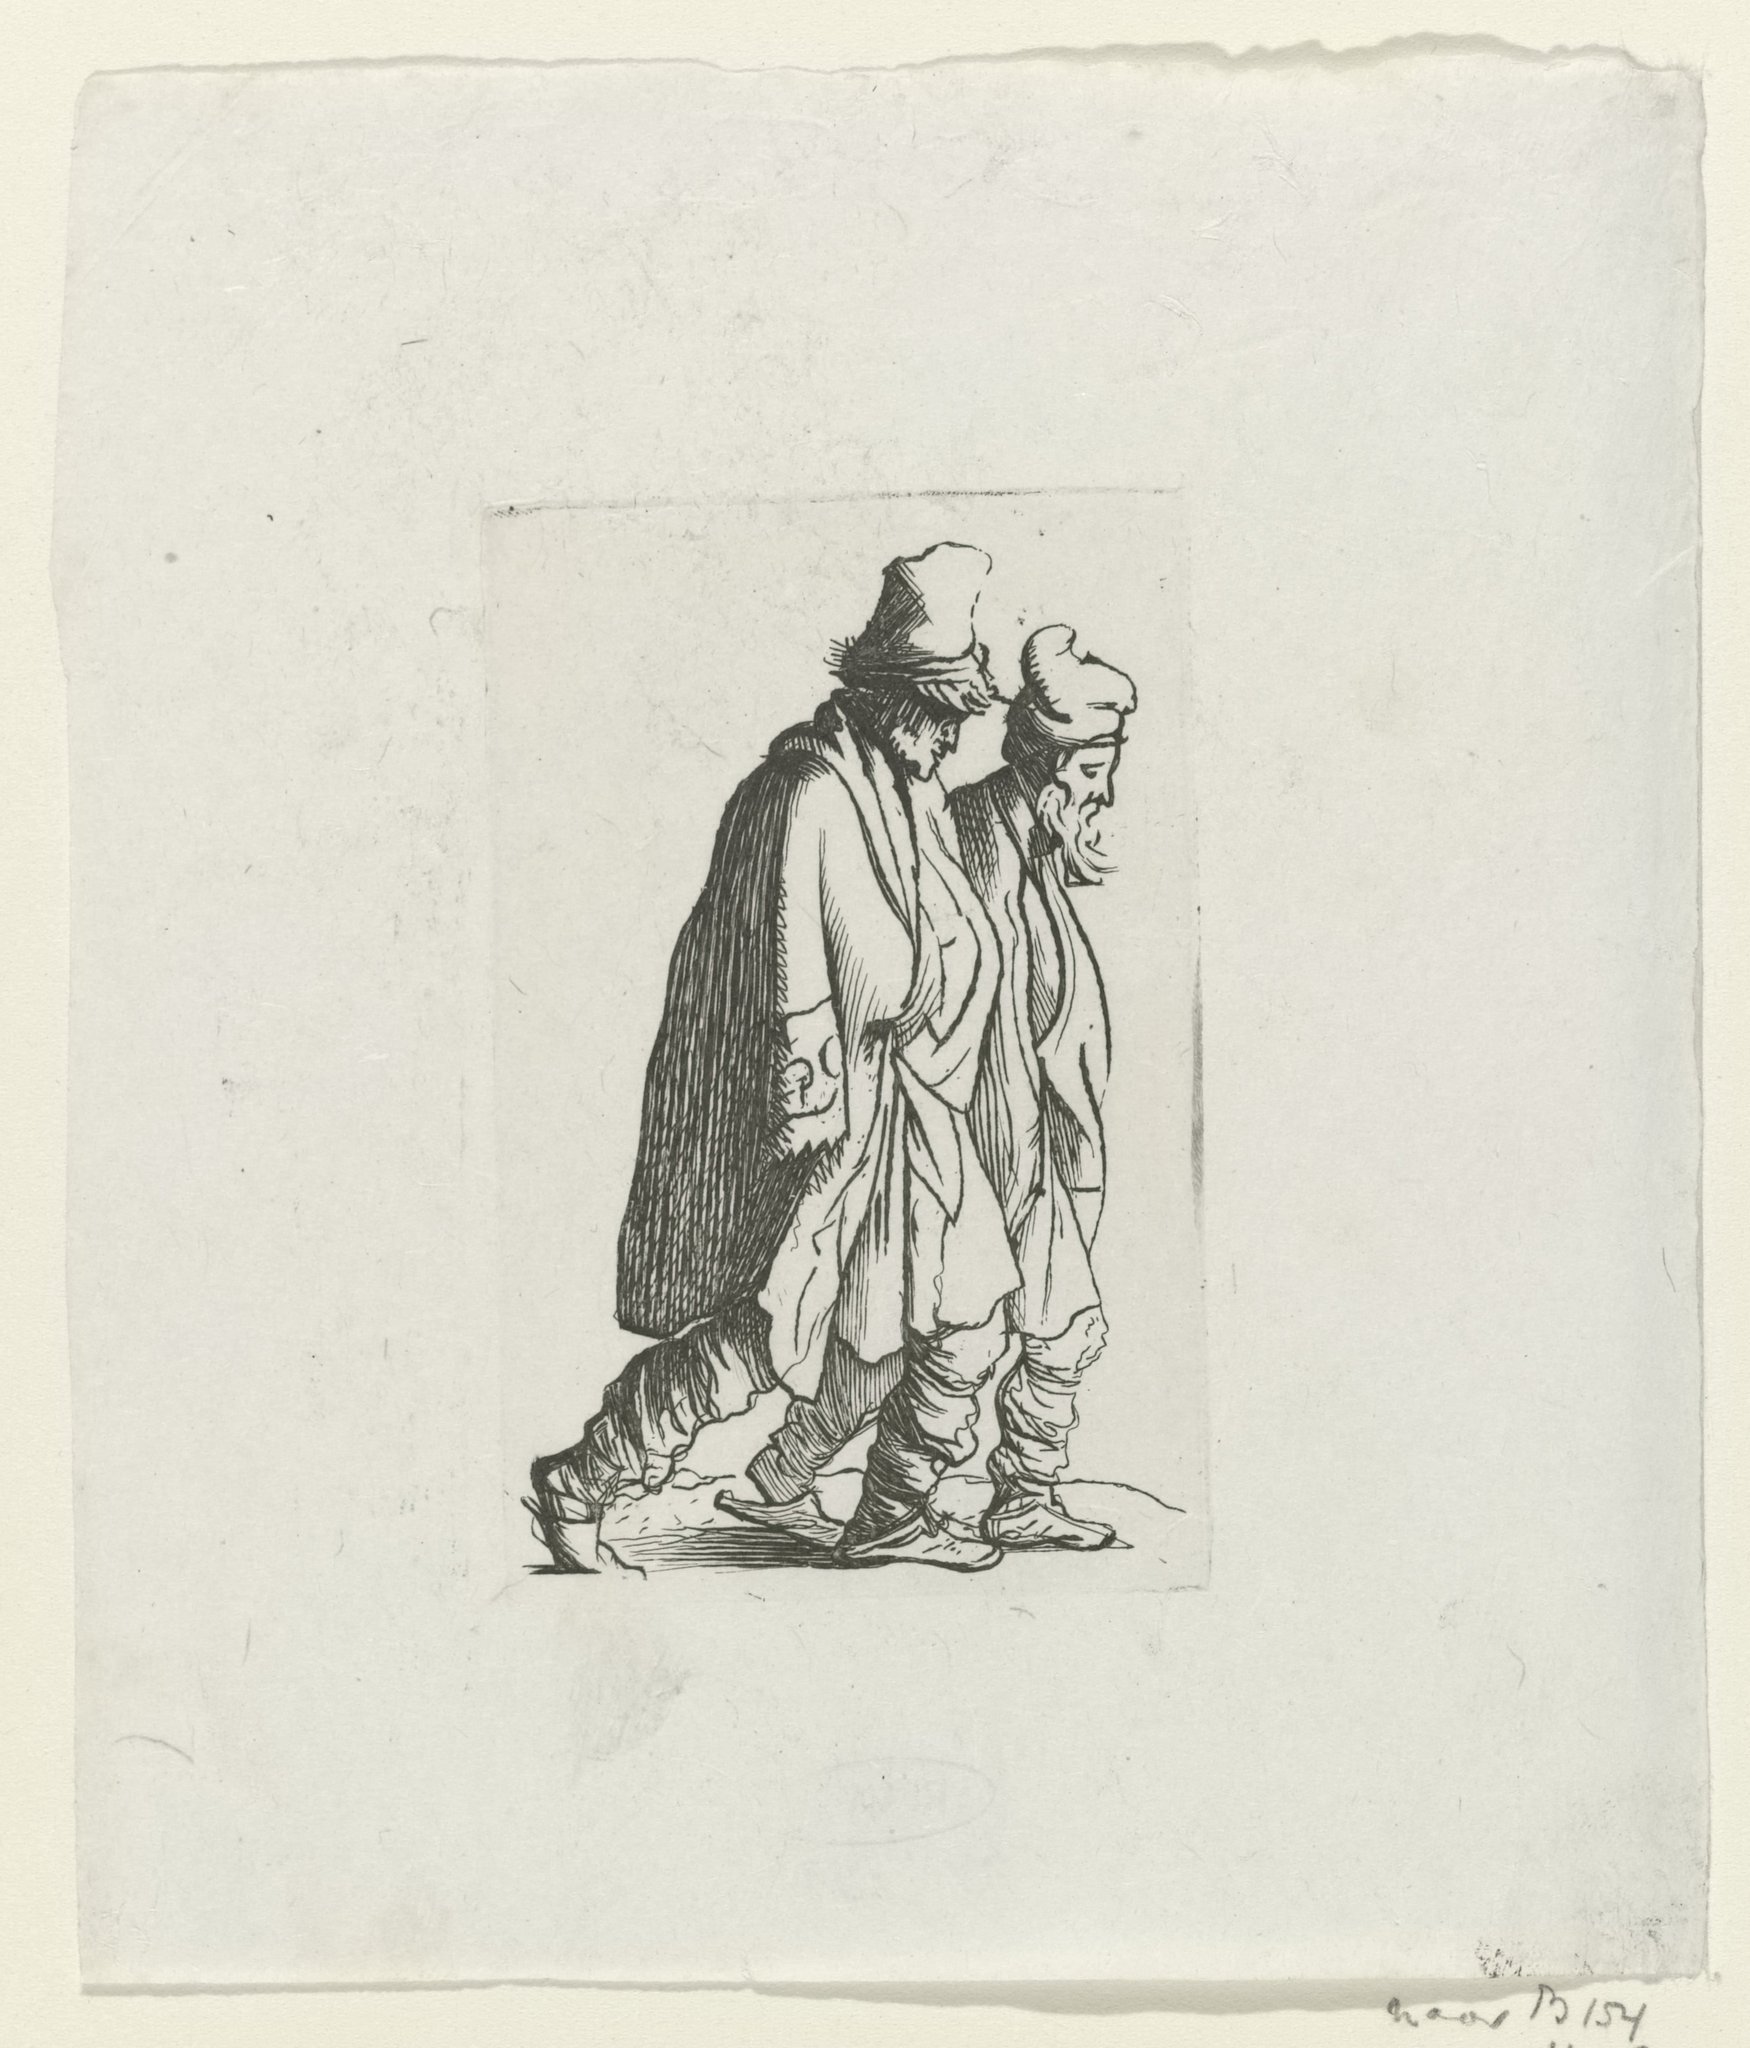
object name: print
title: Twelve Facsimile Etchings from very rare Originals by Rembrandt van Ryn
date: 1824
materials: paper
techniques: etching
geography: london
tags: beggar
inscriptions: collector's mark: Lugt 2228